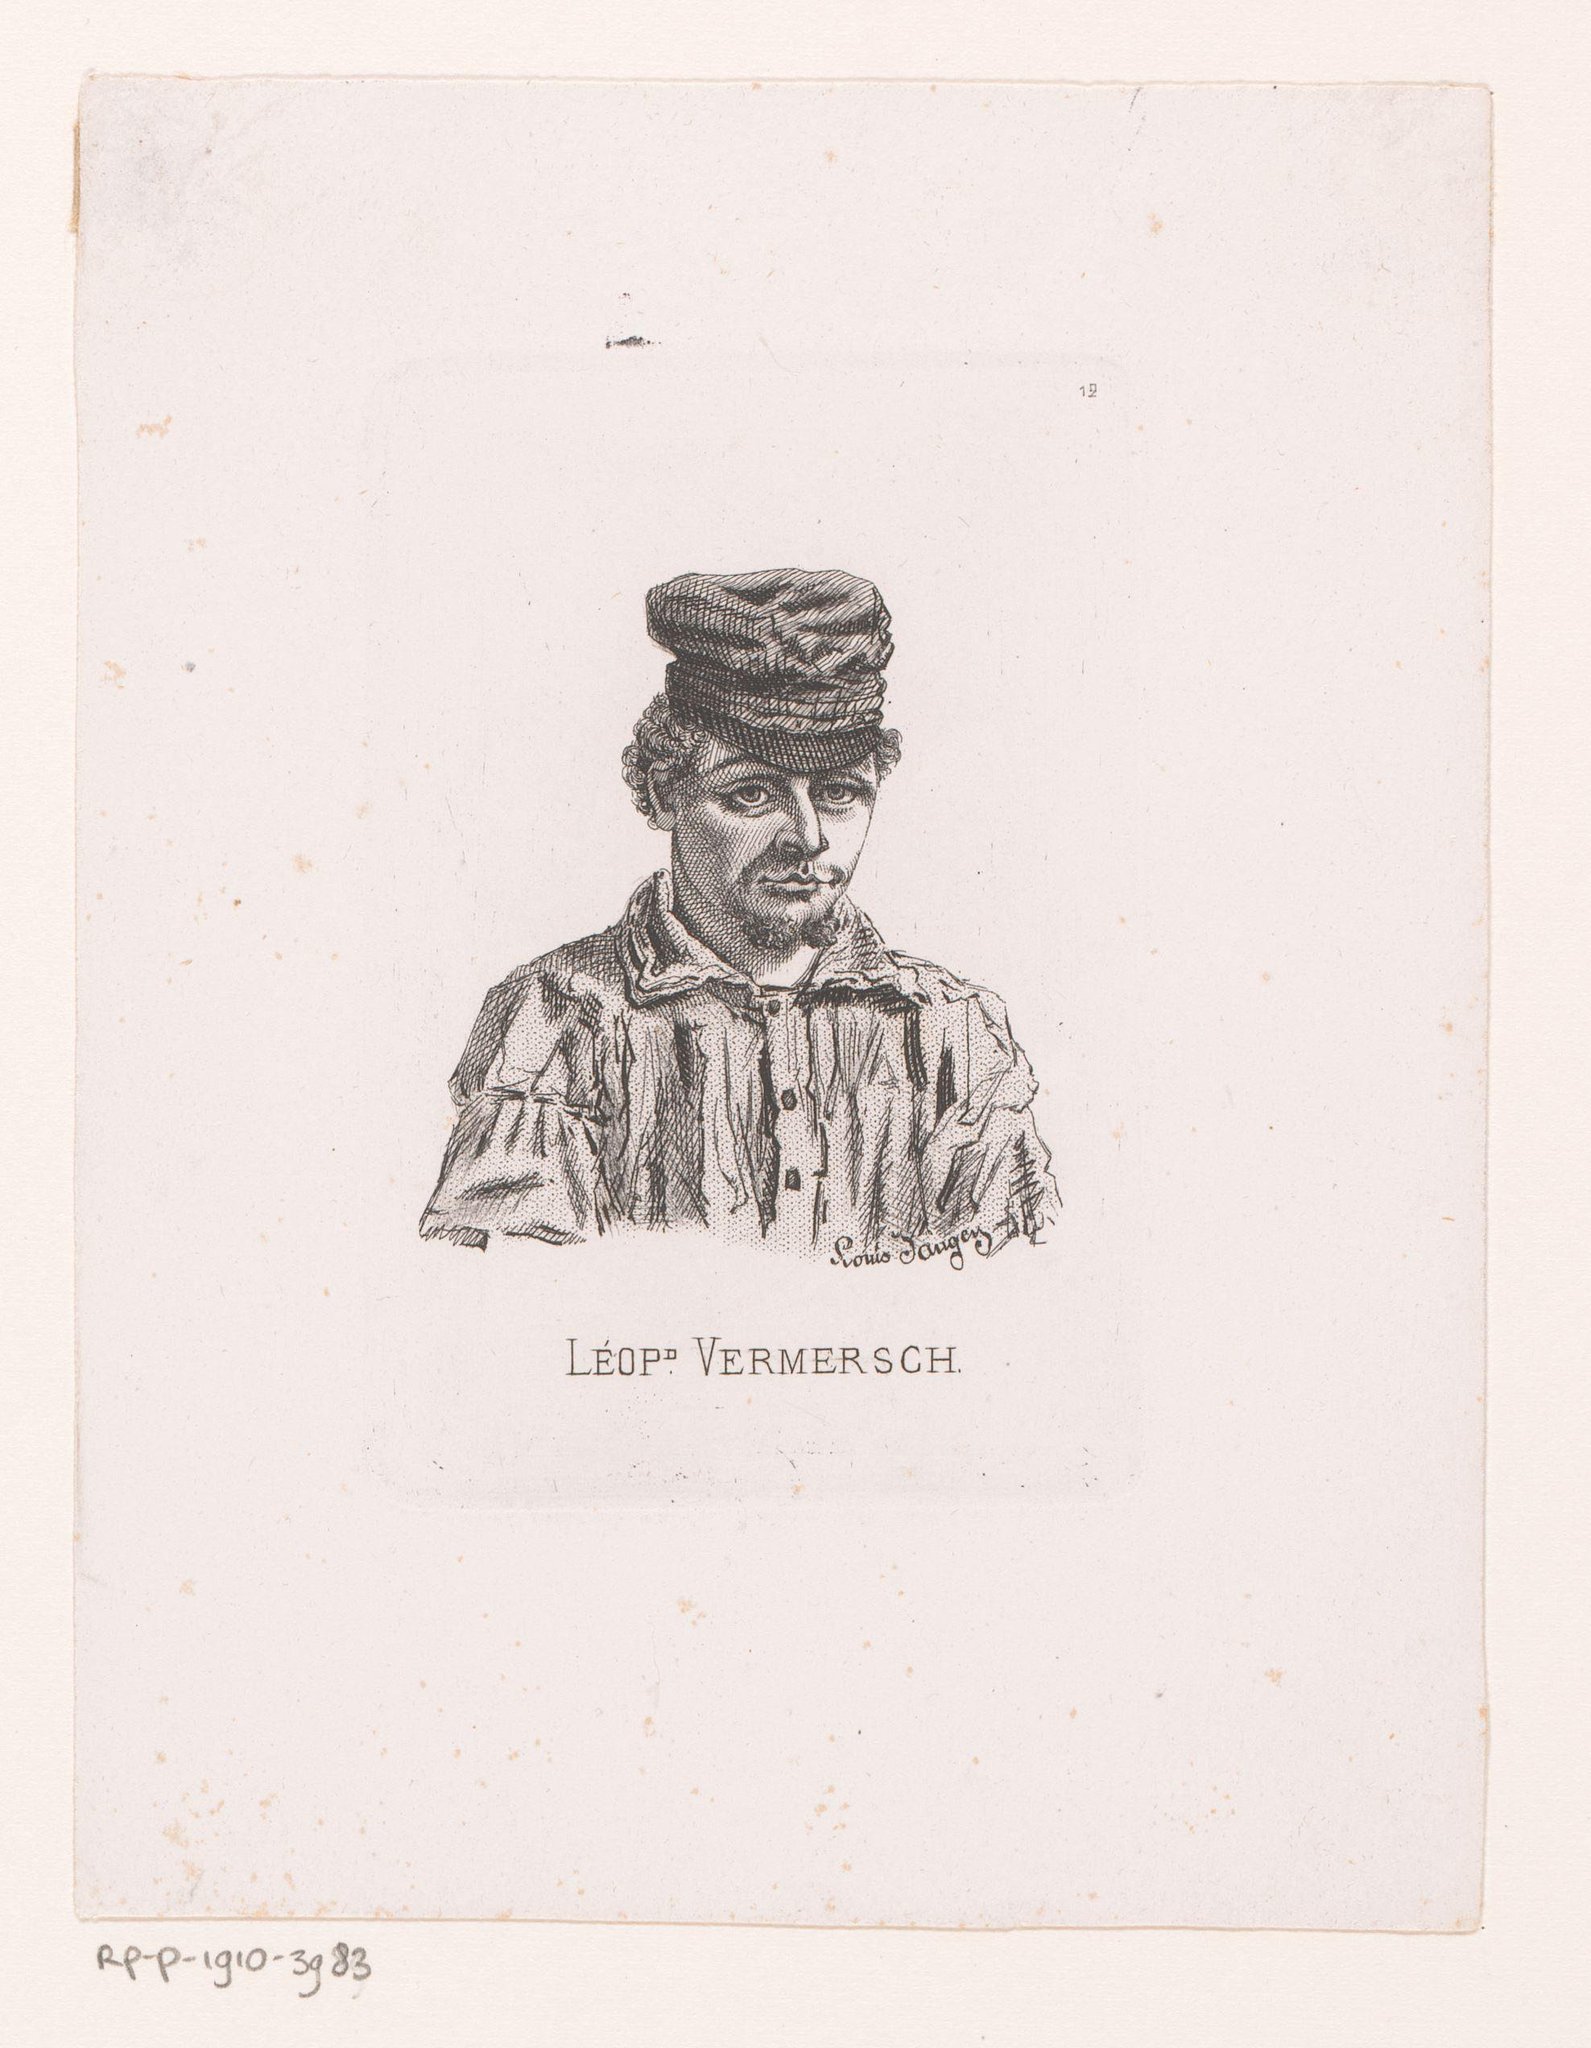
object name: print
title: Portret van Léopold Vermersch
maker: louis jaugey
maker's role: print maker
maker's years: 1837-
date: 1850-1899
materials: paper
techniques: etching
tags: head-gear, adult man, historical persons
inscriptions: collector's mark: Lugt 2228